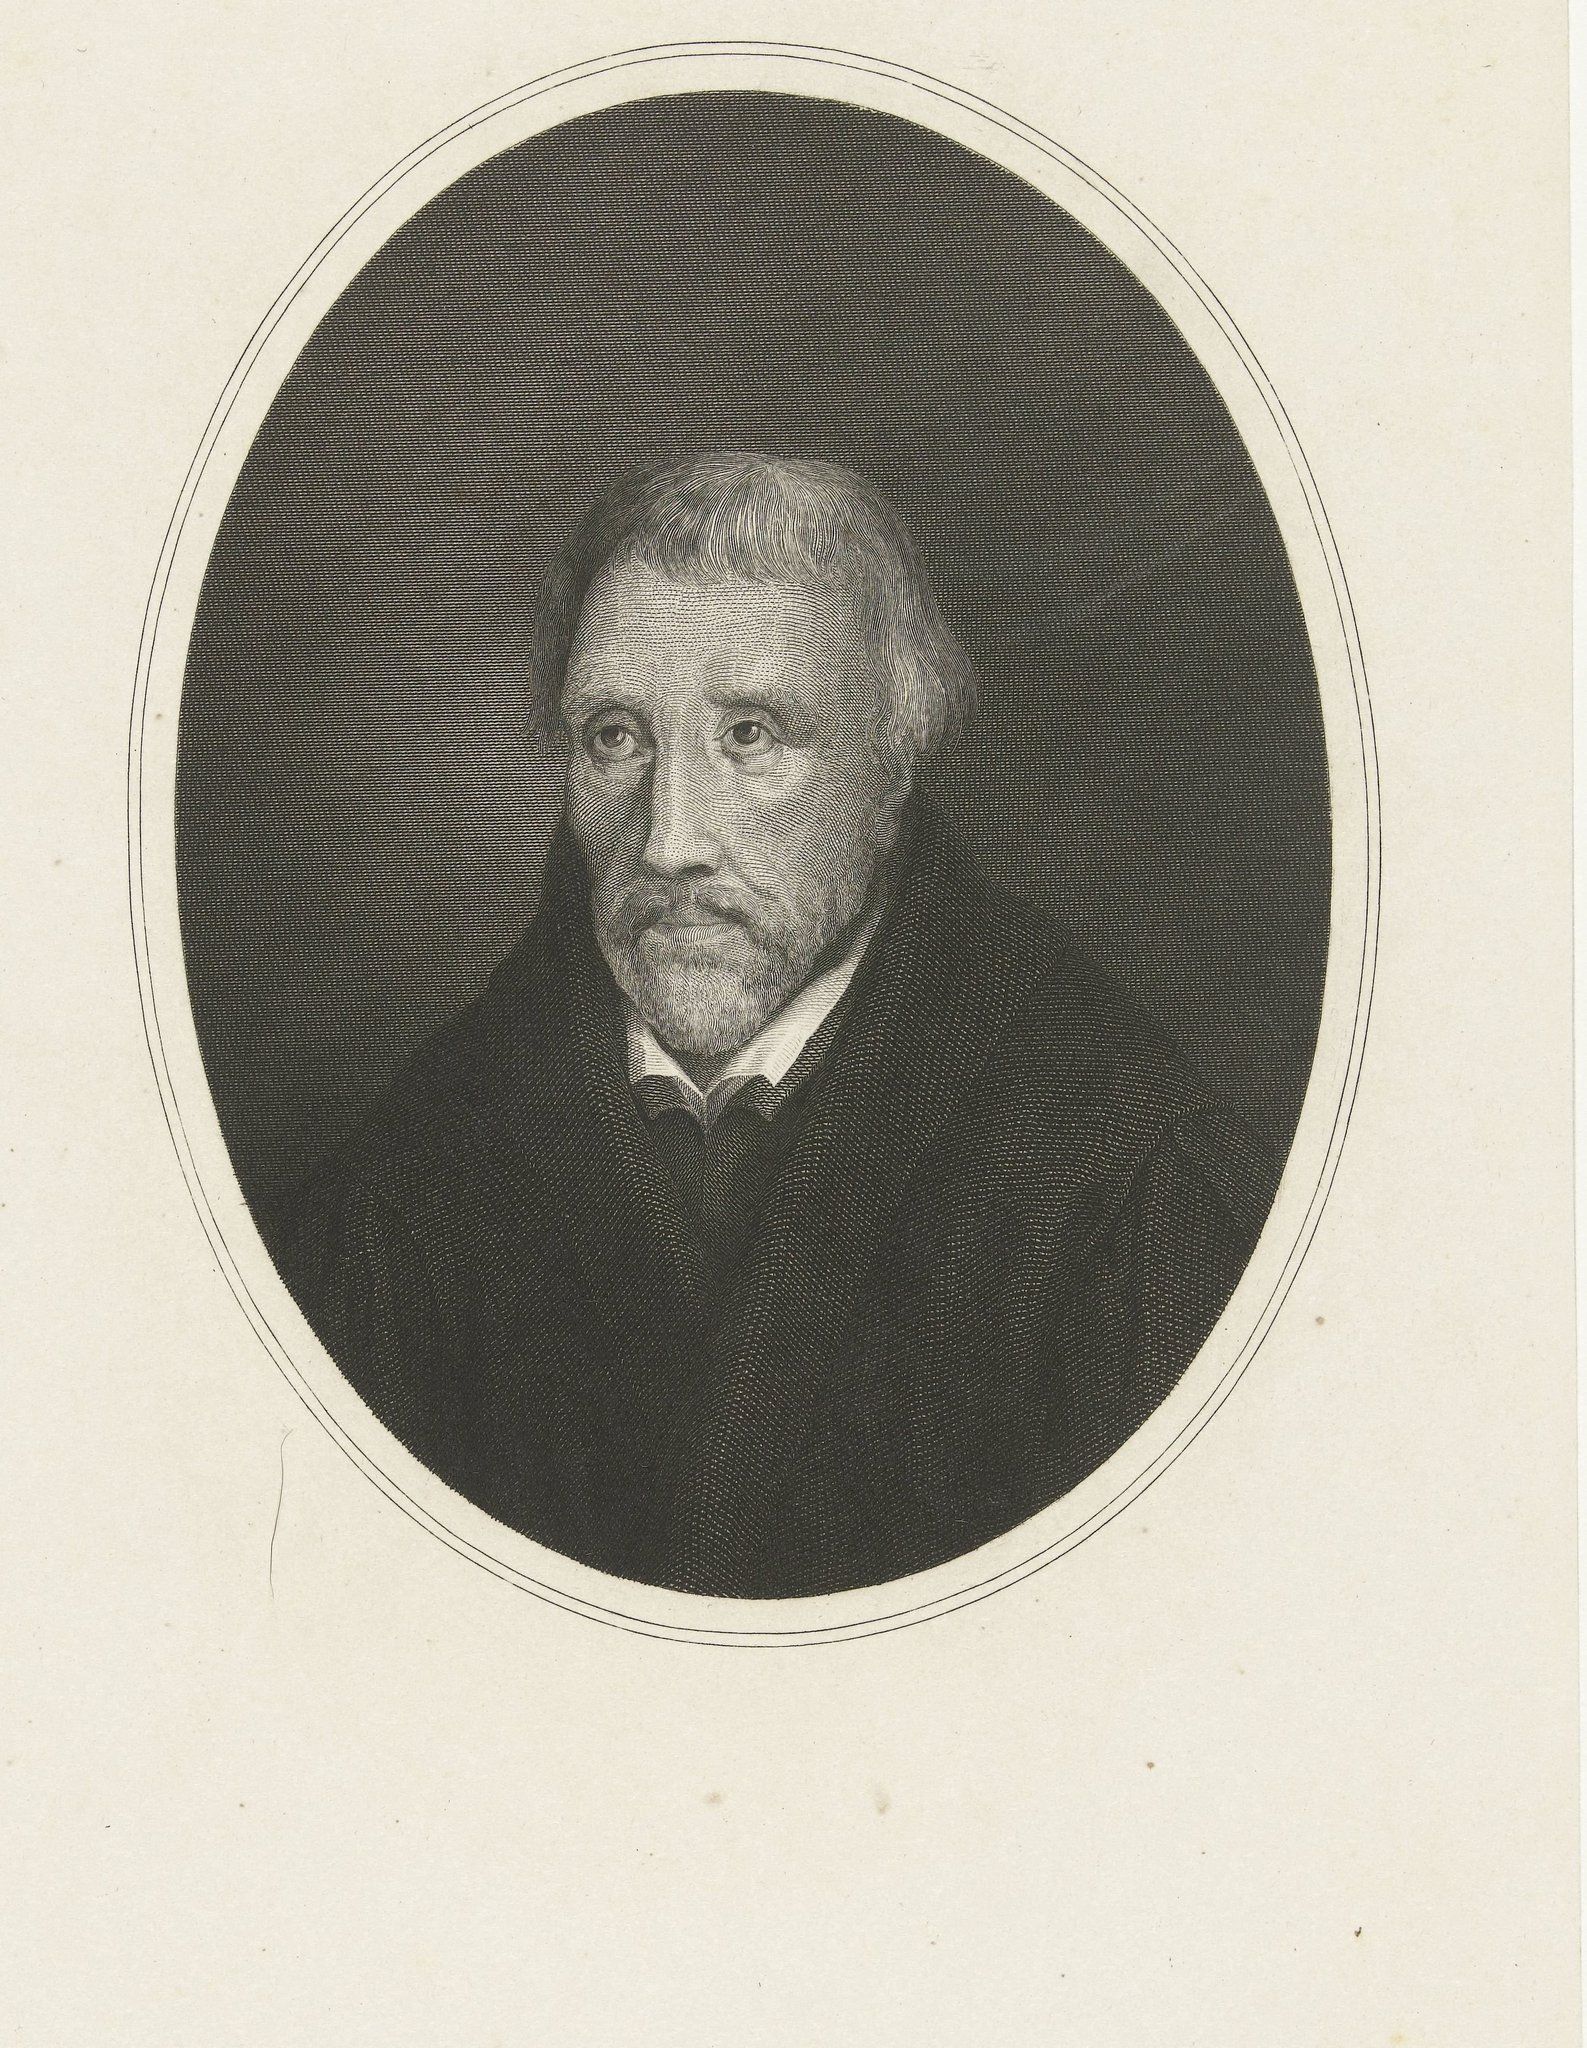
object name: print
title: Mansbuste in ovaal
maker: henricus wilhelmus couwenberg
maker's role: draughtsman, print maker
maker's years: 1814-1845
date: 1829-1845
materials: paper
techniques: engraving, etching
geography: amsterdam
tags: anonymous historical person portrayed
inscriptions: collector's mark: Lugt 2228